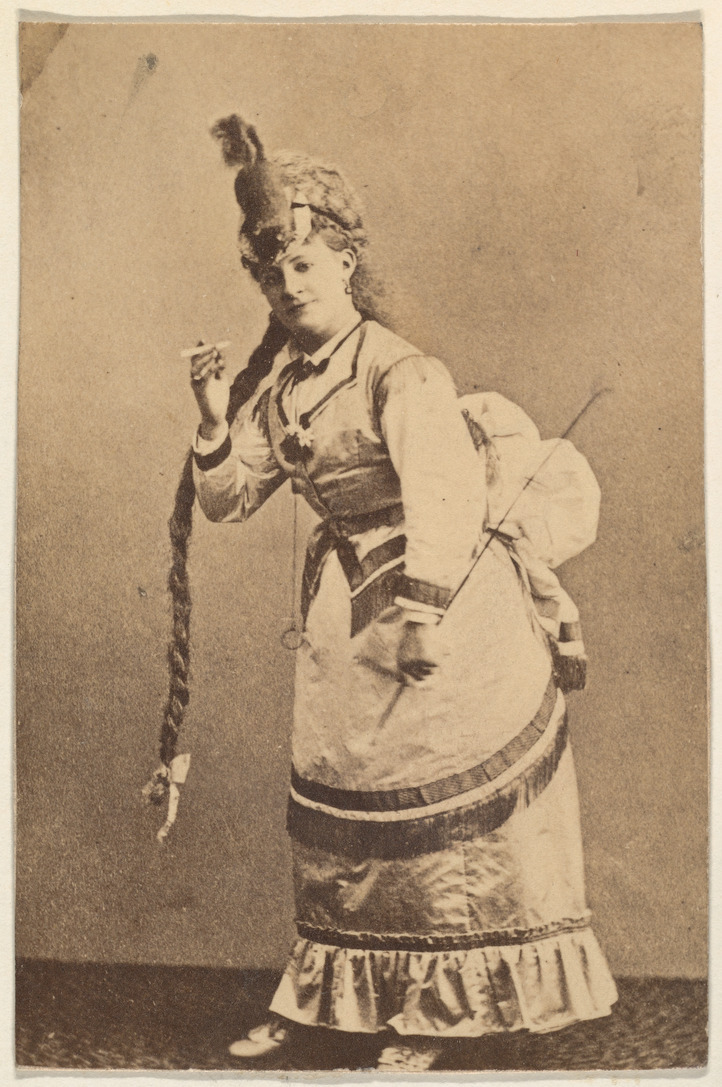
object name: photograph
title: Actress with knee-length braid, from the Actresses series (N668)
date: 1888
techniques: albumen silver print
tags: portraits,women,actresses